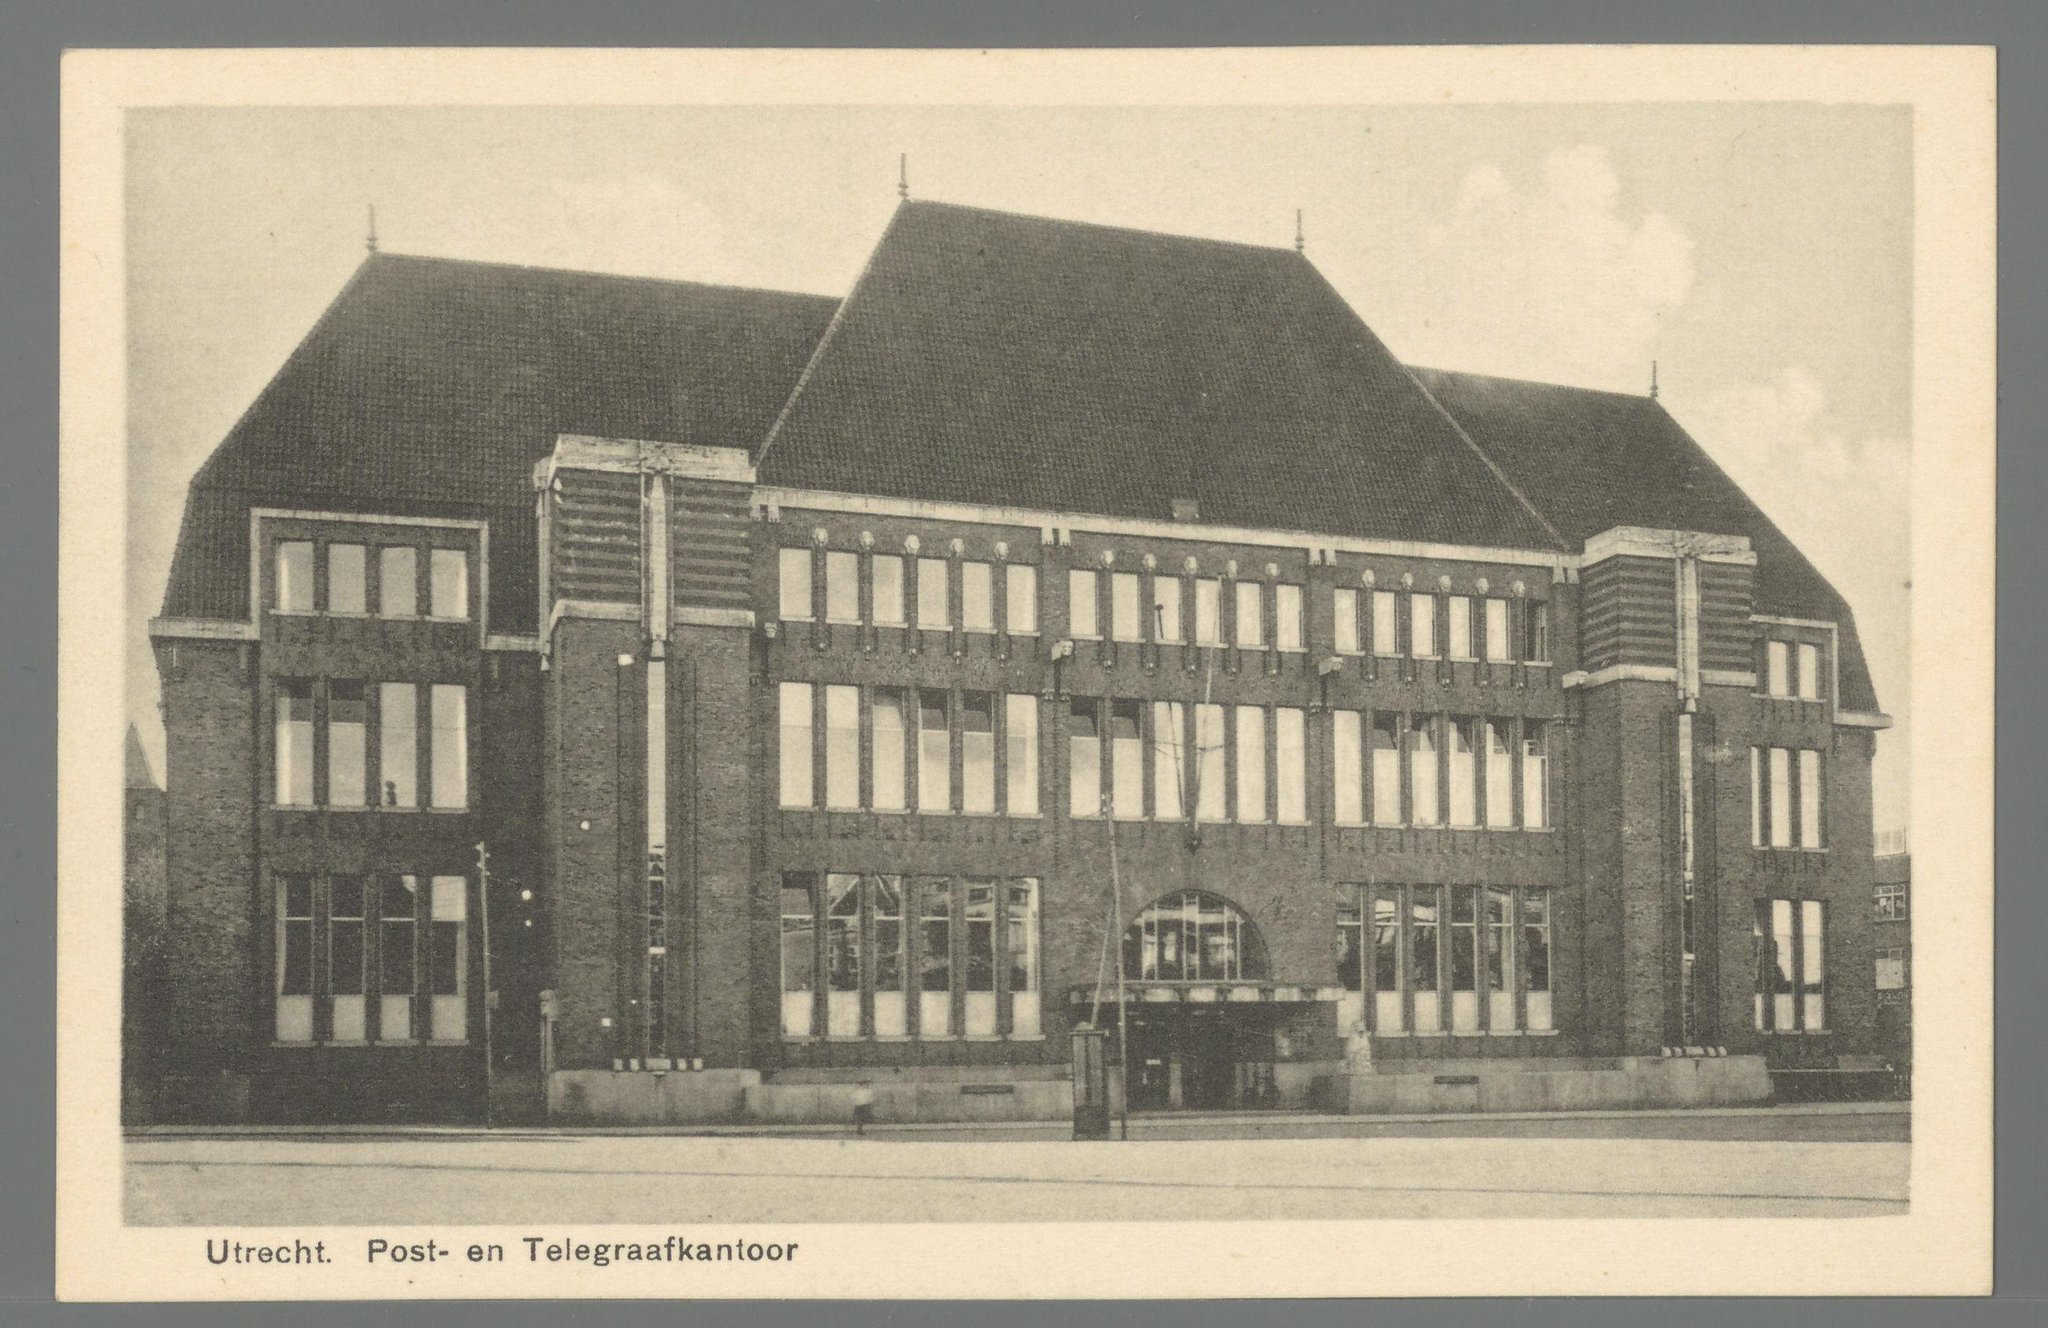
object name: photomechanical print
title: Utrecht. Post- en Telegraafkantoor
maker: Anonymous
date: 1920-1930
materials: cardboard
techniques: photograph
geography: oosterhout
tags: post-office, utrecht